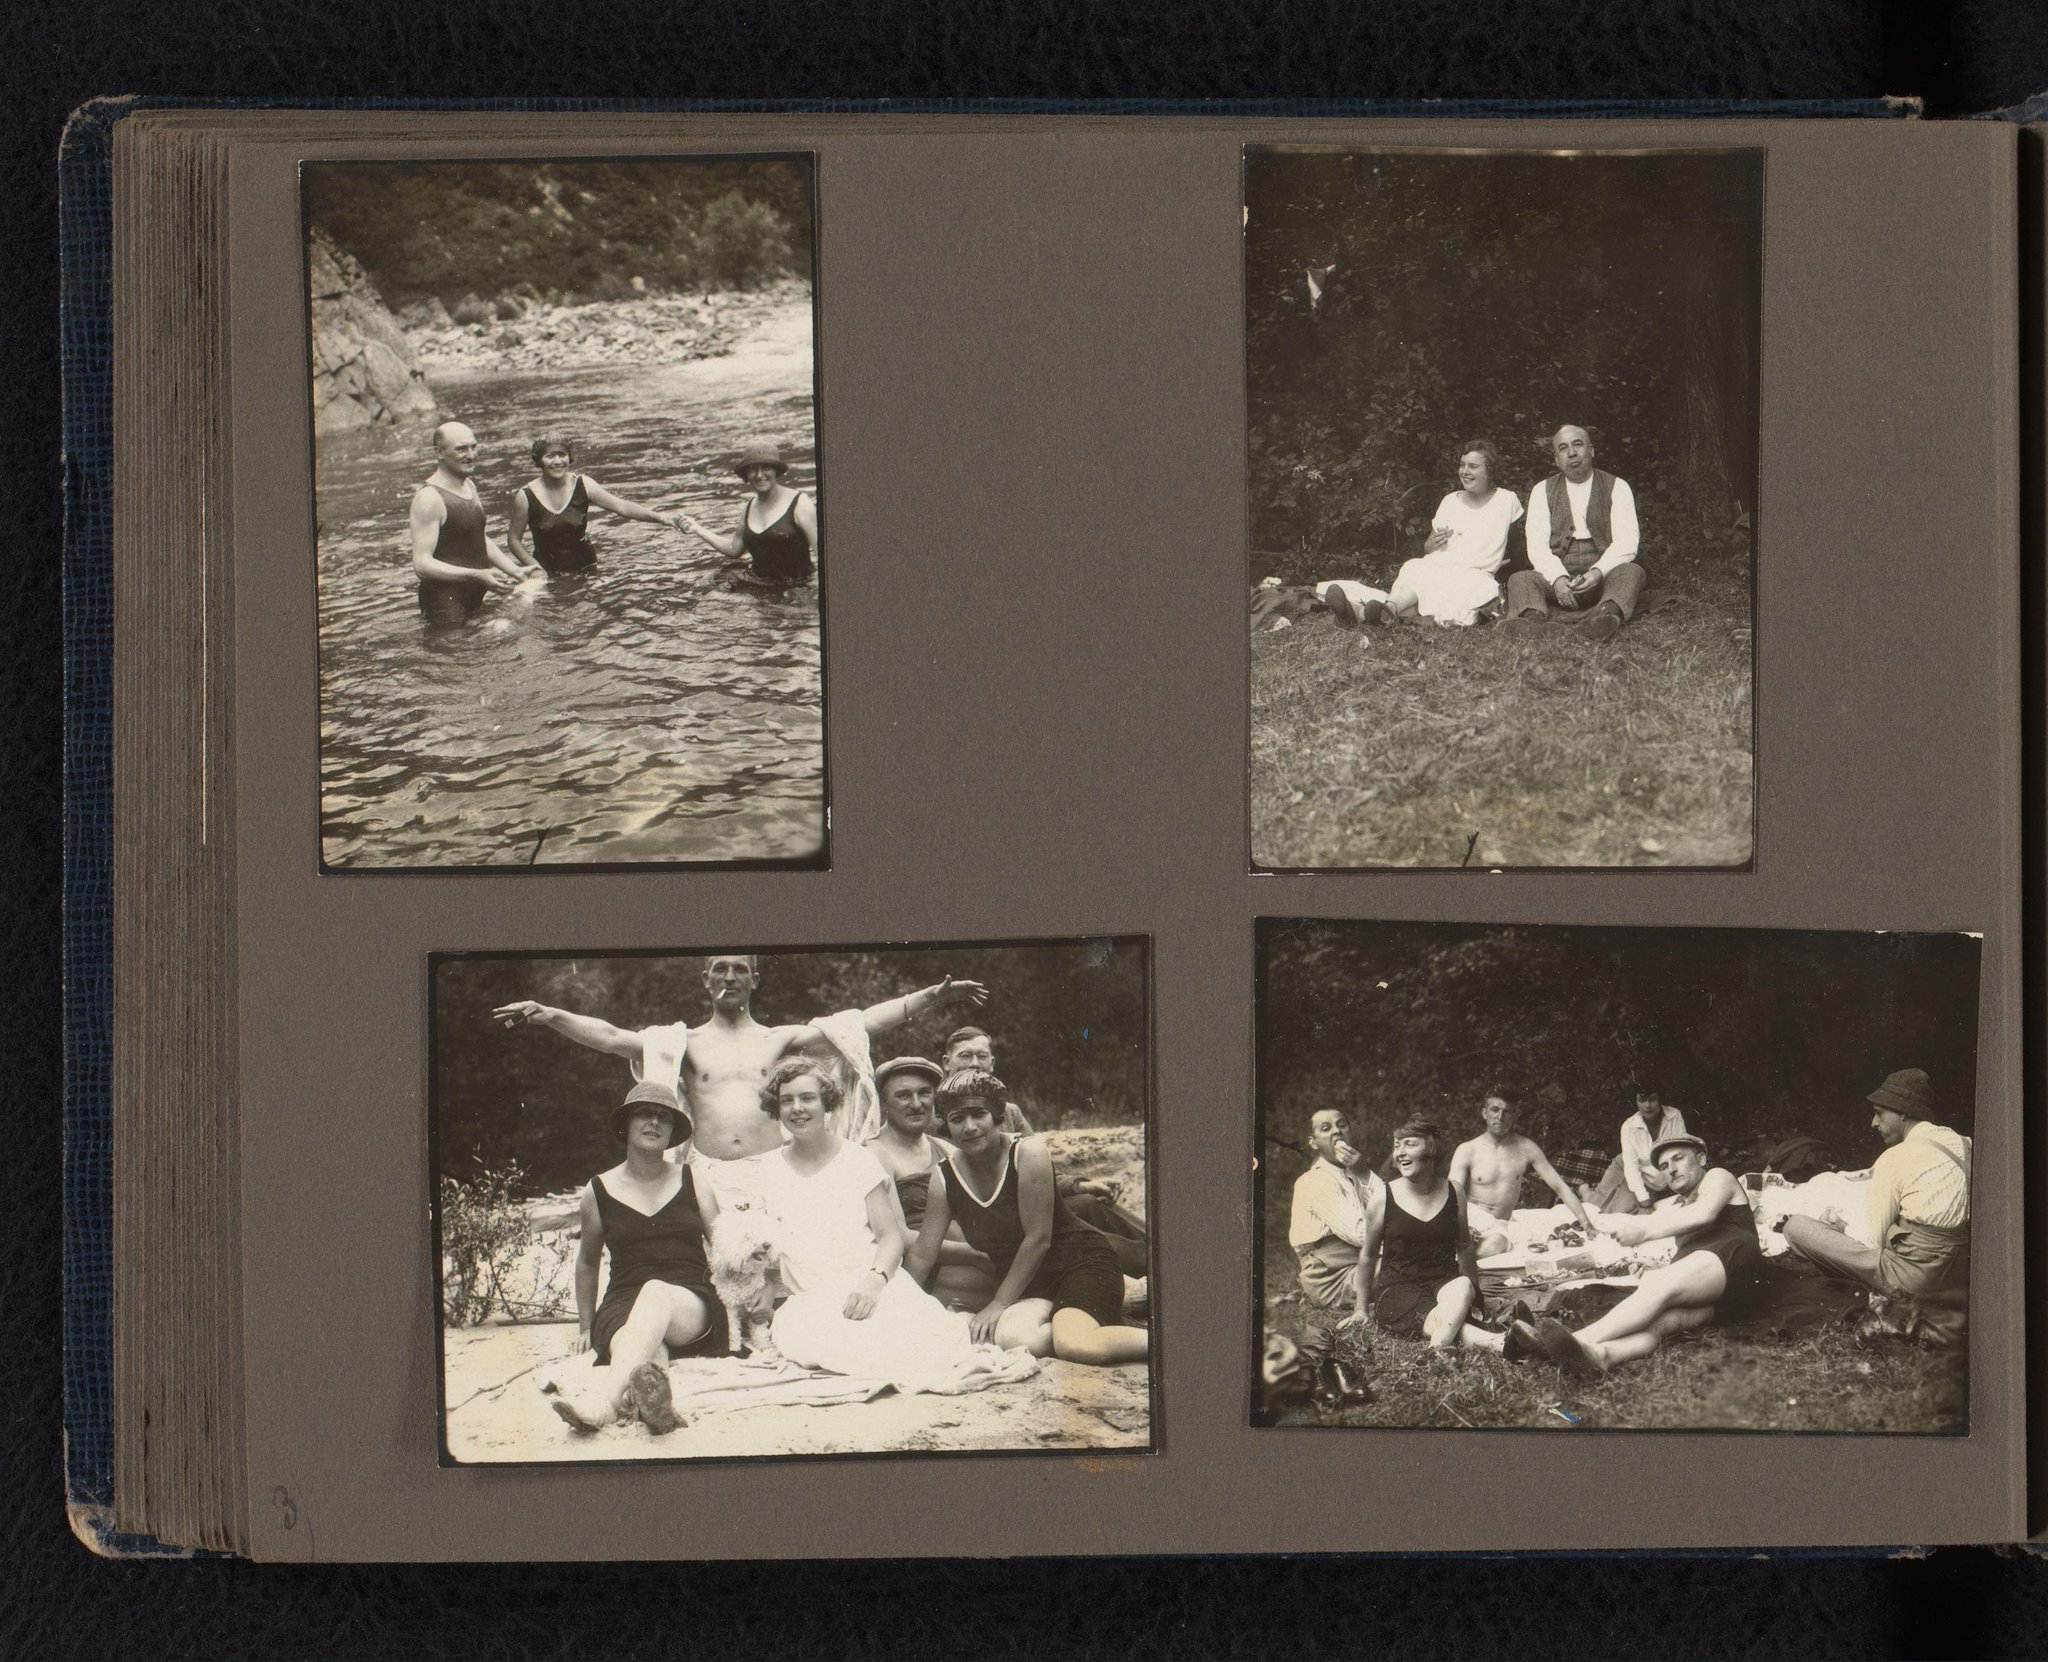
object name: photograph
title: Onbekende mensen in vrijetijdsbesteding, mei 1928, Sofia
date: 1905-1928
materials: paper, photographic support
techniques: gelatin silver print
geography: sofia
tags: the family travelling, on holiday, river, swimming (sport)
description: Albumblad bevat vier foto's van onbekende personen. Uit album half formaat, blauw kunstlederen omslag met koordbinding.